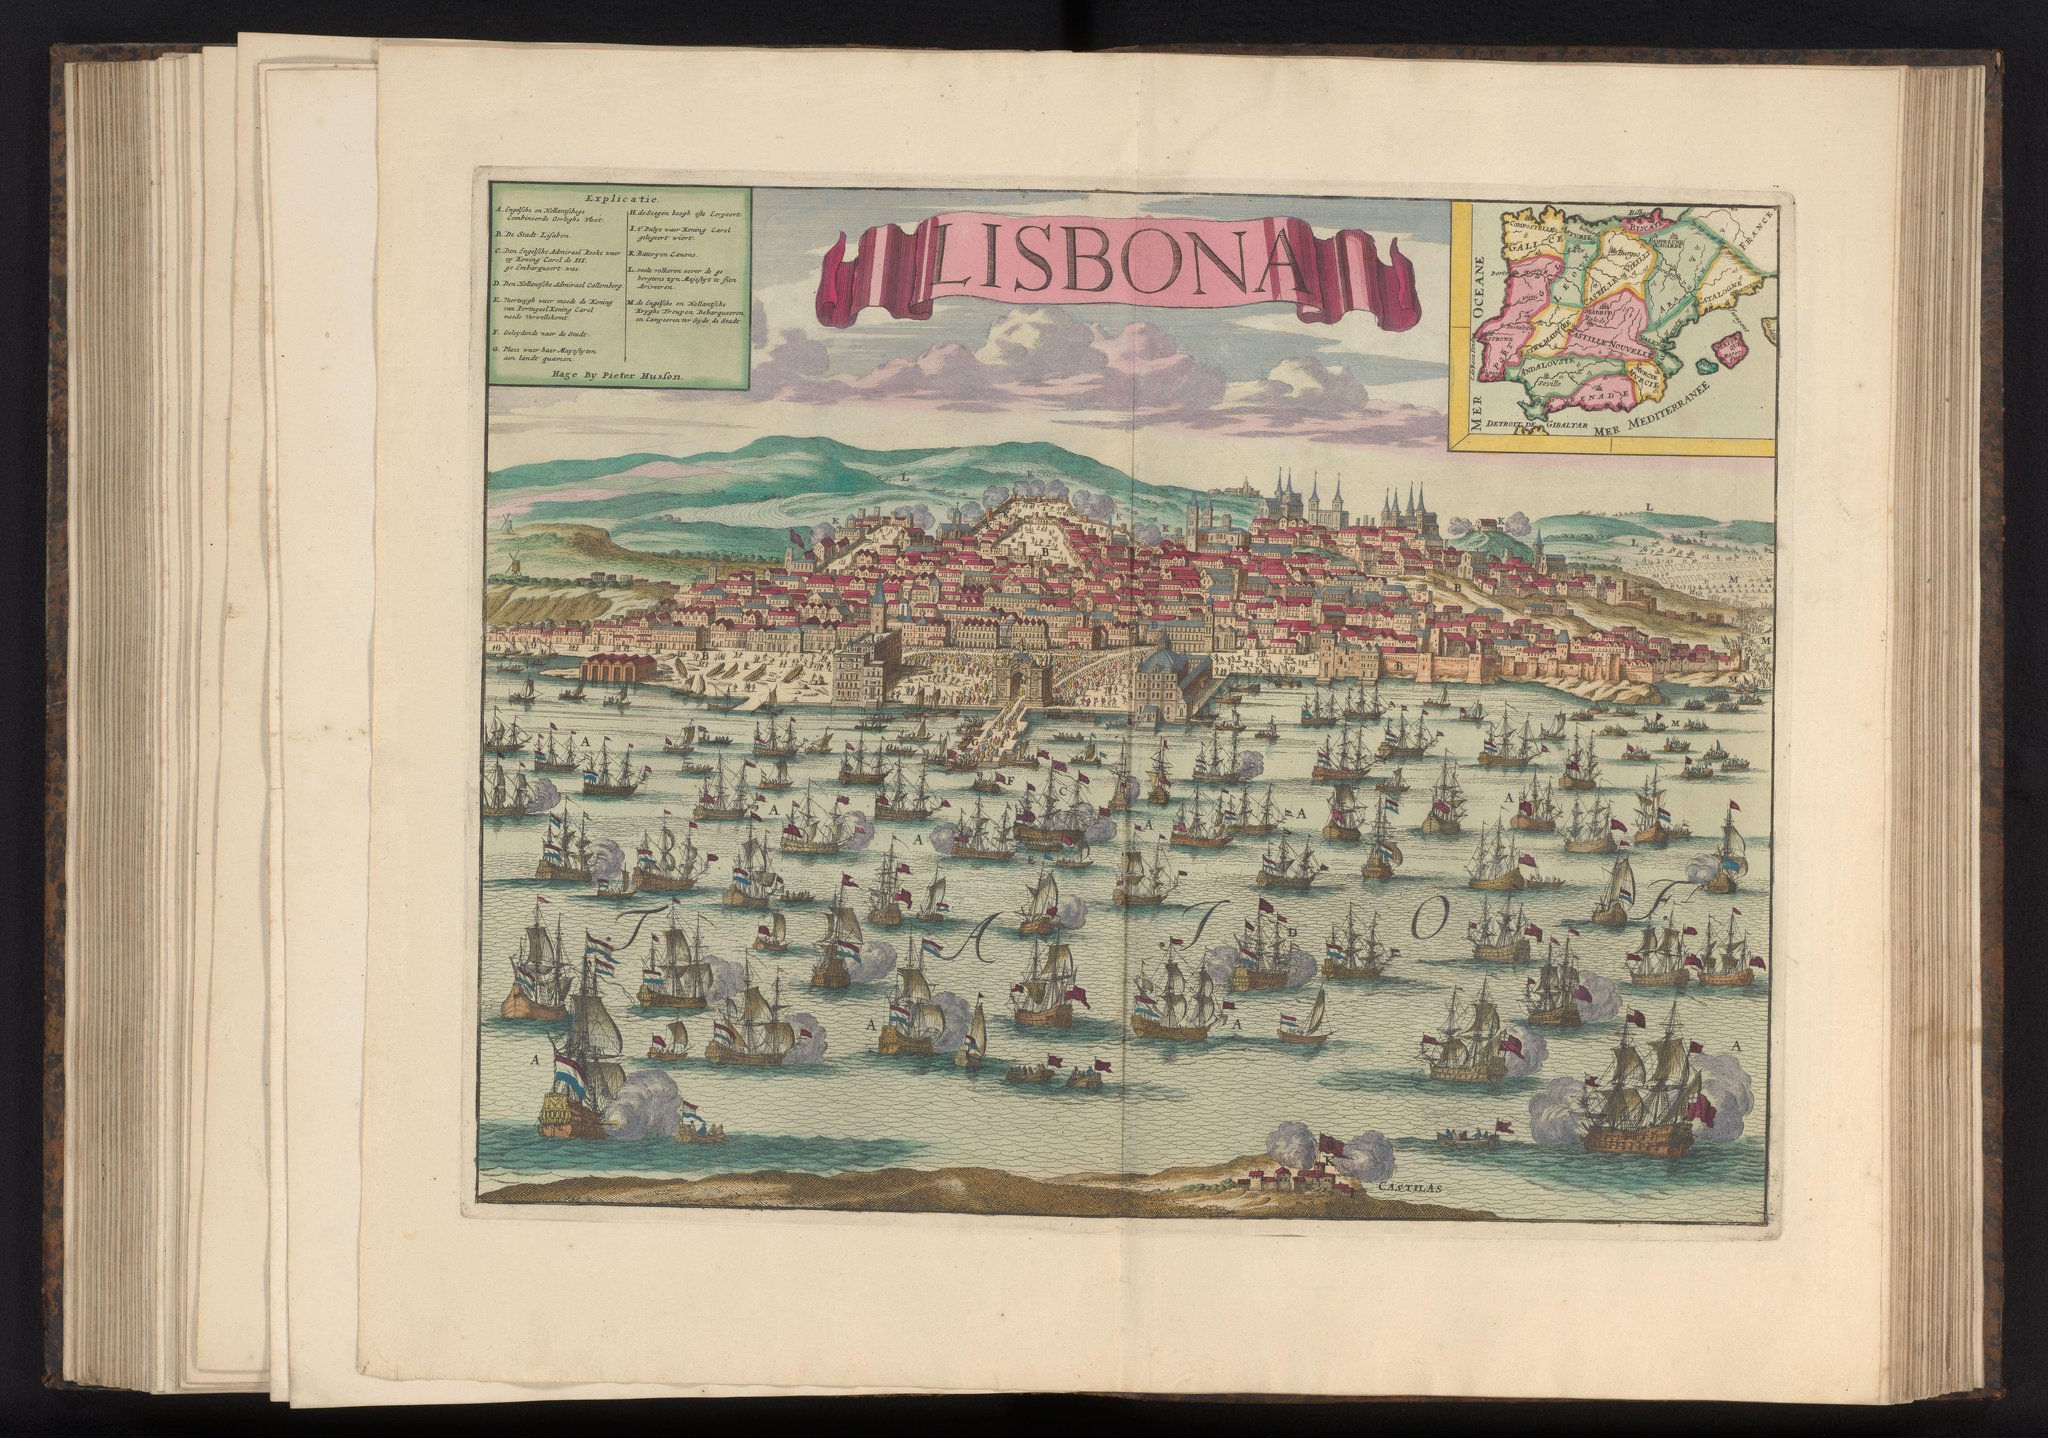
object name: print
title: Aankomst van de Hollands-Engelse vloot met koning Karel III te Lissabon, 1704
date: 1704-1732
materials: paper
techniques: engraving, etching, hand coloring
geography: northern netherlands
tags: vienna, charles vi (holy roman emperor), city-view in general; 'veduta'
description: Aankomst van de Hollands-Engelse vloot met aan boord koning Karel III (aartshertog Karel van Oostenrijk) te Lissabon, 7 maart 1704. Gezicht op Lissabon met de schepen van de vloot op de rivier de Taag voor de stad. Linksboven de legenda, rechtsboven een inzet met een kaart van Spanje en Portugal. Prent maakt deel uit van een album.